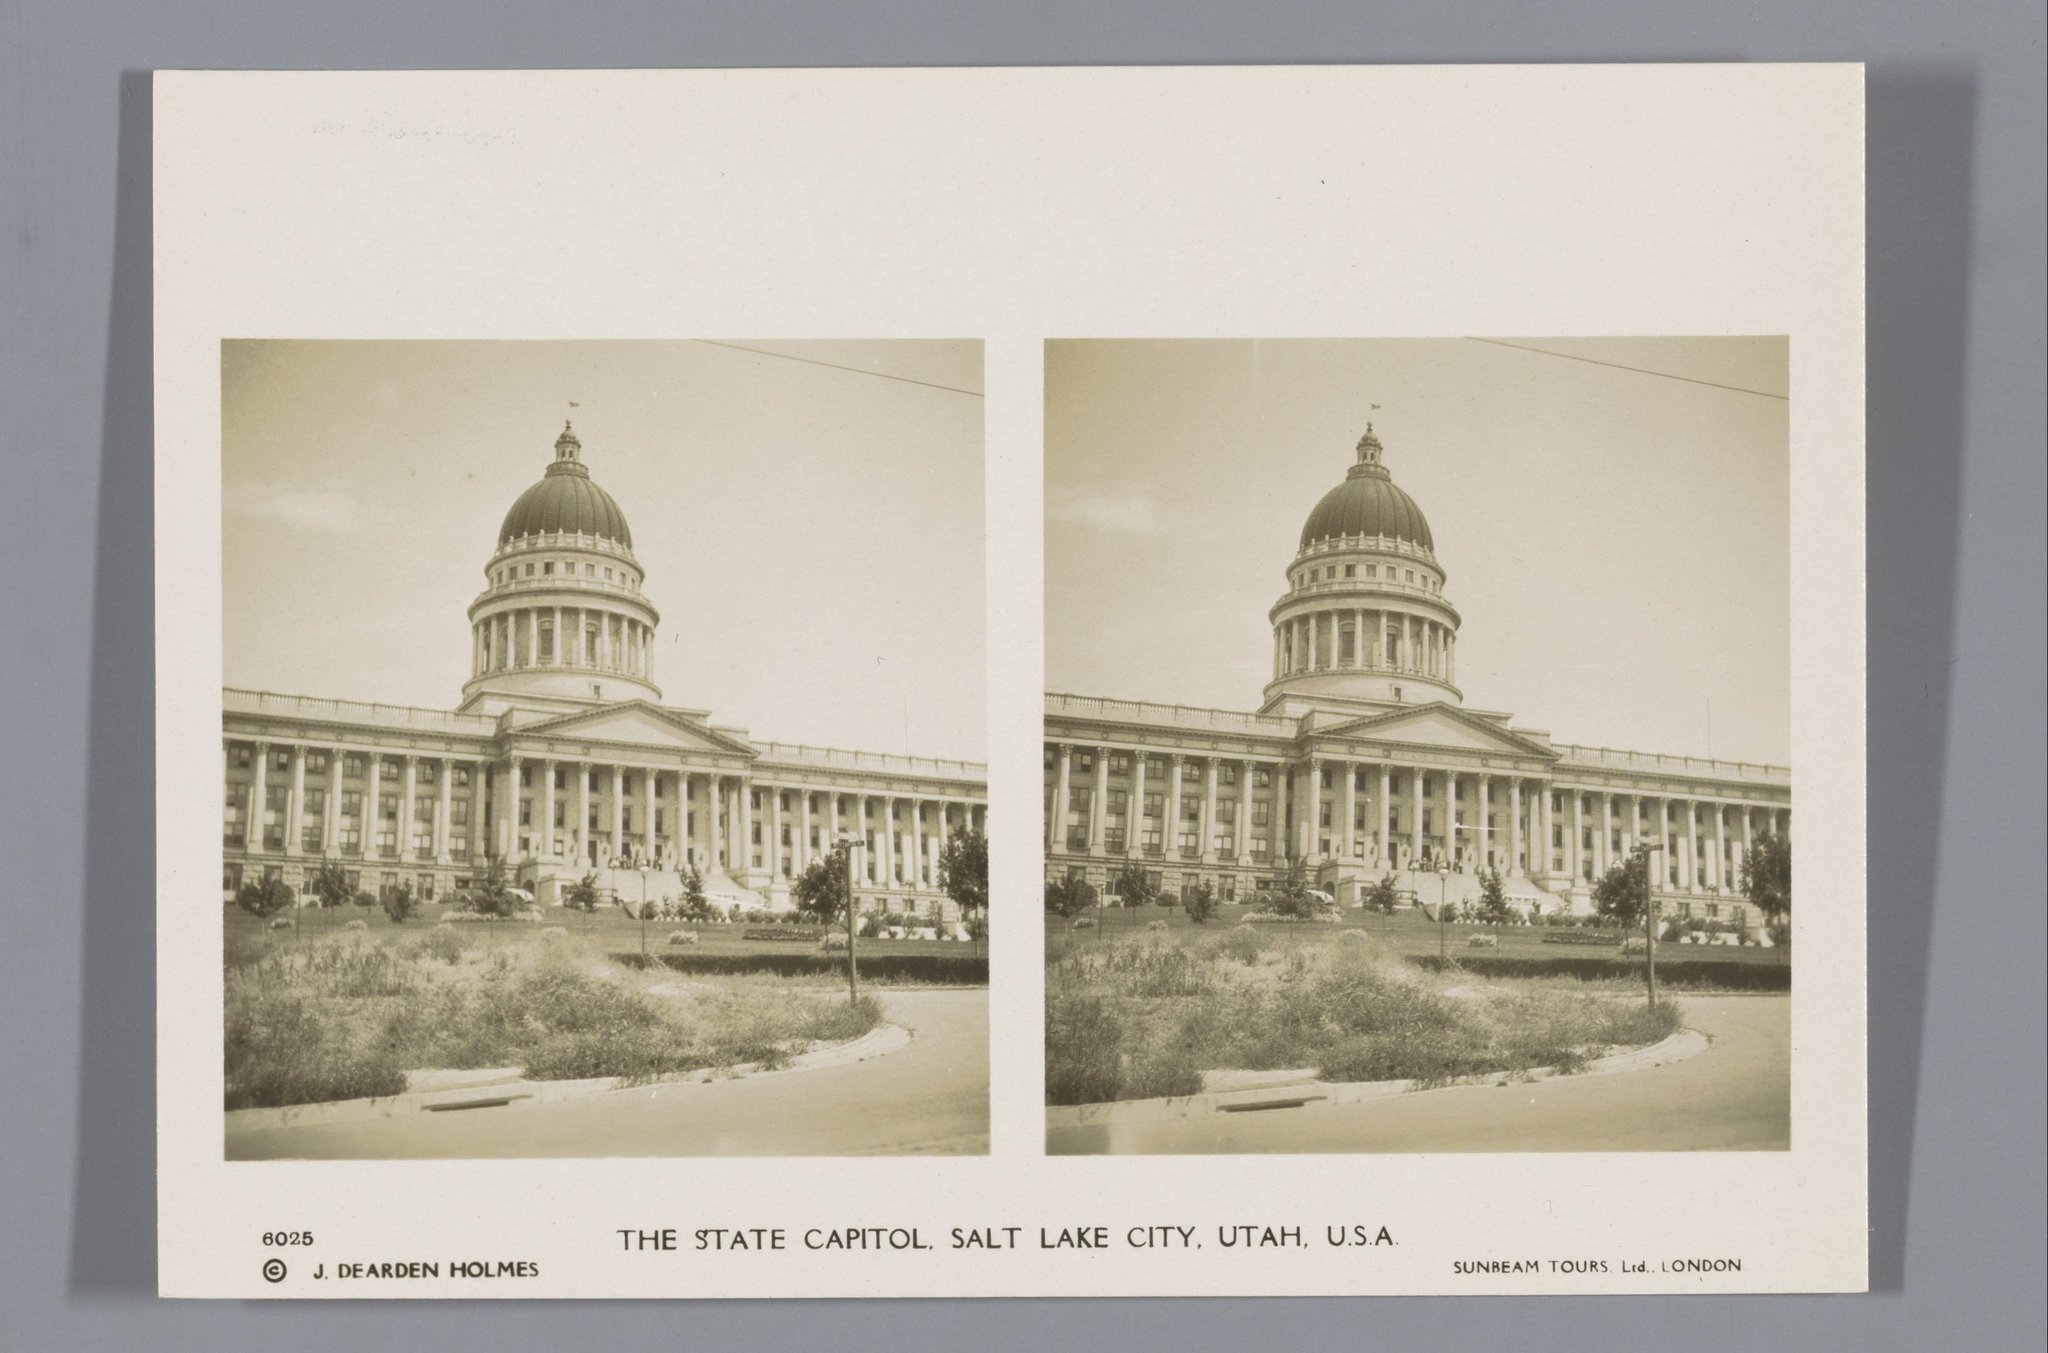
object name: stereograph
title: The State Capitol, Salt Lake City, Utah, U.S.A.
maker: james dearden holmes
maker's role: fotograaf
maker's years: 1873-1937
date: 1924-1926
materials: paper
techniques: gelatin silver print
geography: birmingham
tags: townhall, edifice, e.g.: public building, department store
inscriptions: number: ‘6025’